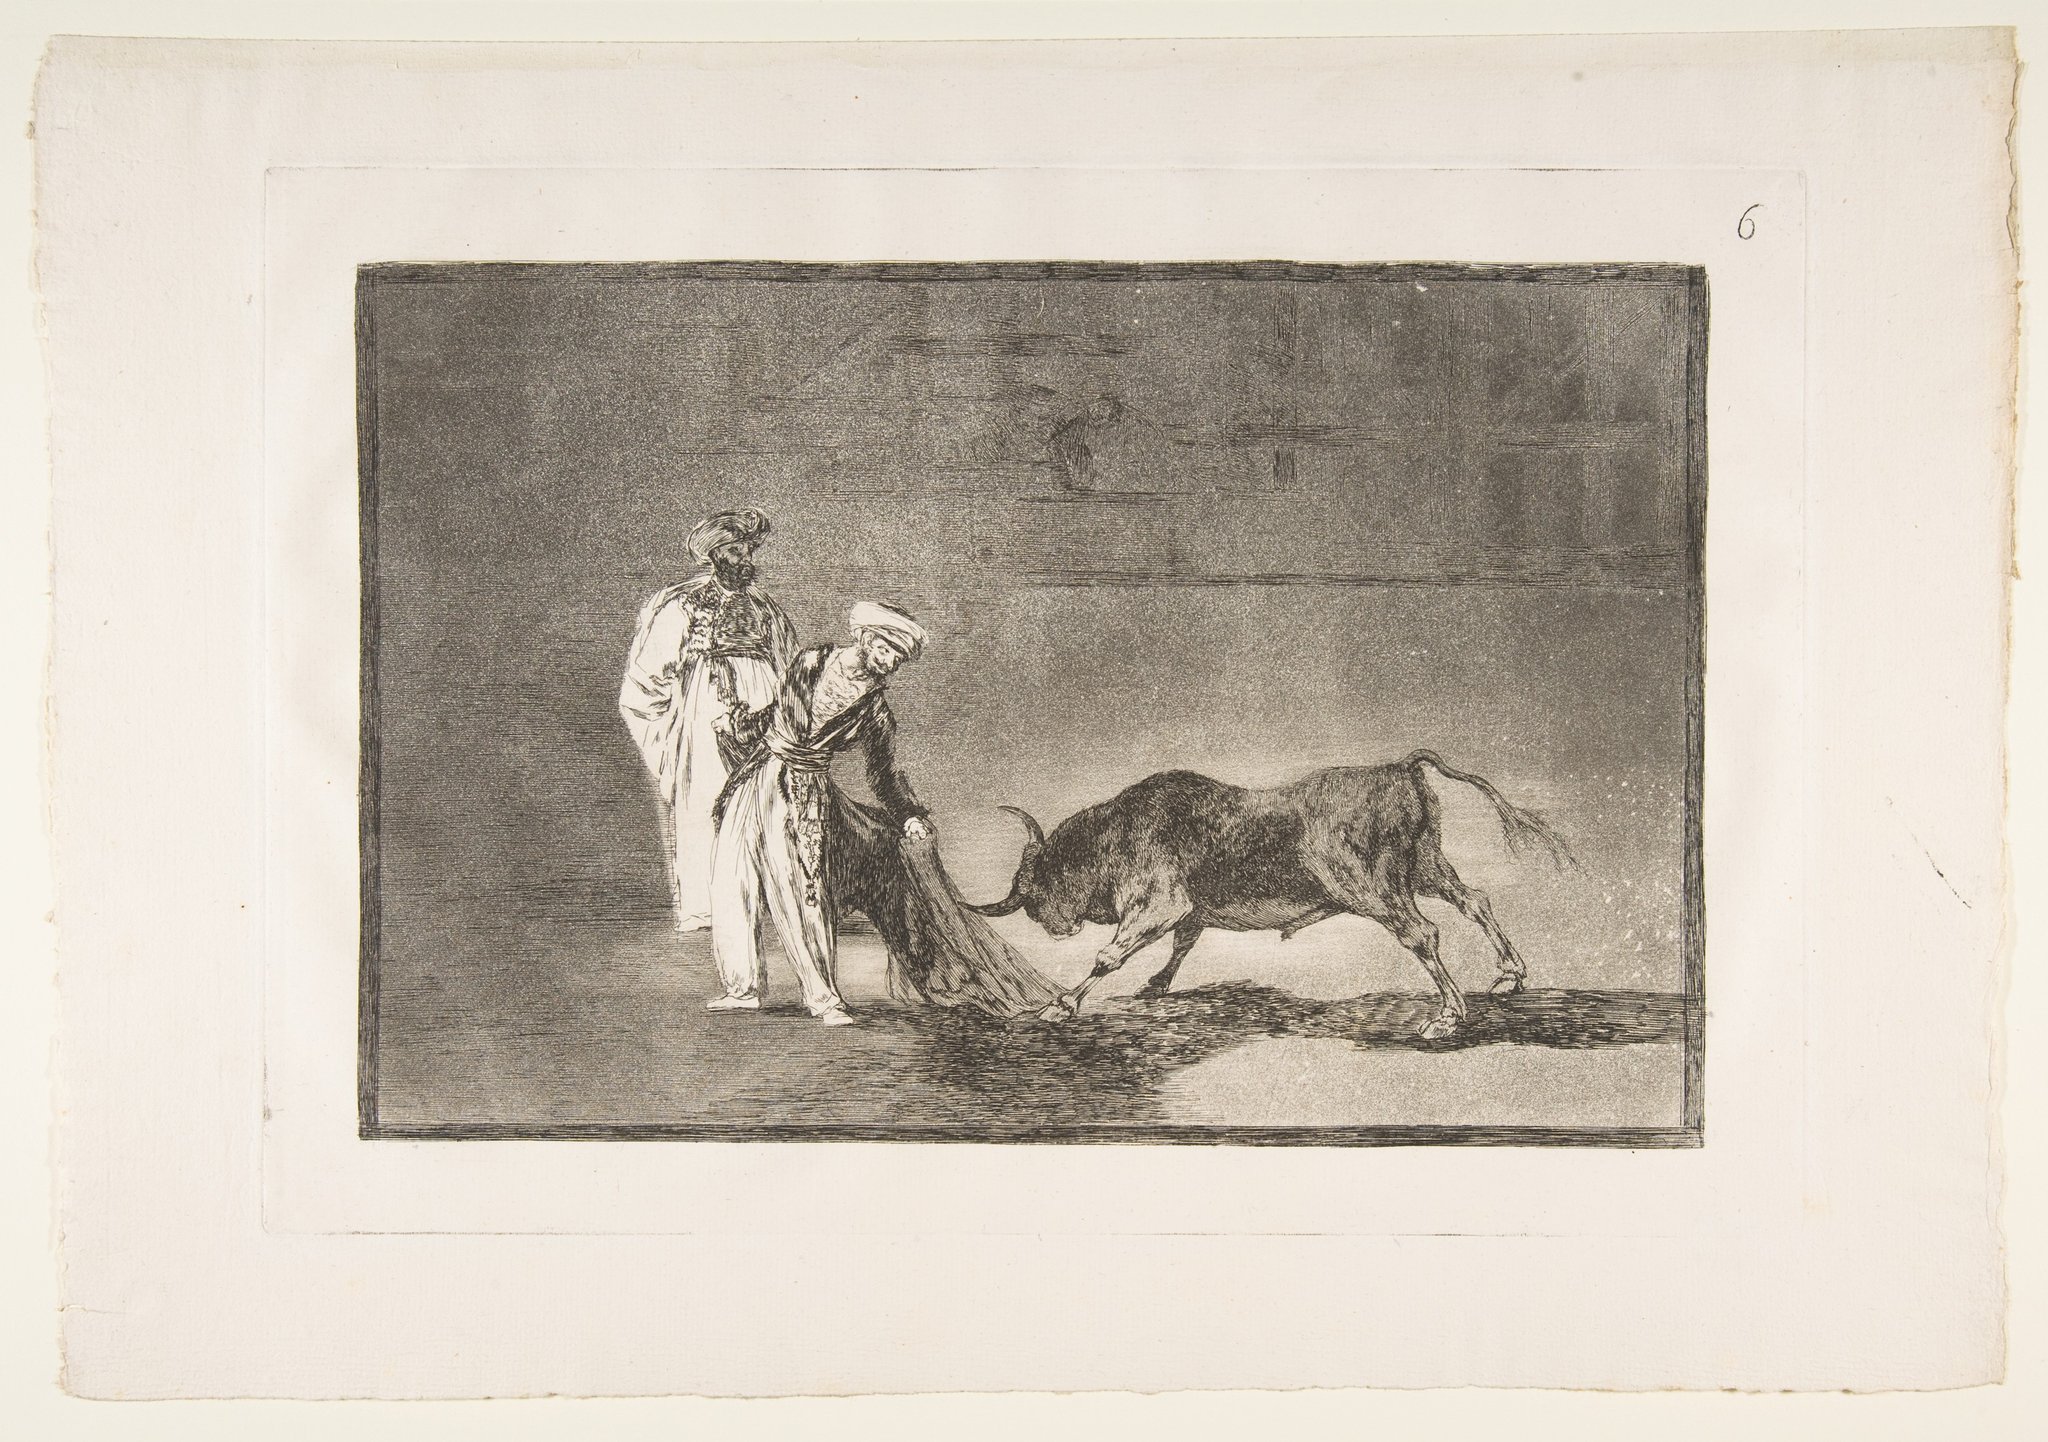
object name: print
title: Plate 6 from "La Tauromaquia": The Moors make a different play in the ring calling the bull with their burnous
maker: goya (francisco de goya y lucientes)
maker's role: artist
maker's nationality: spanish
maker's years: 1746-1828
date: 1816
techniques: aquatint, burnishing, drypoint, etching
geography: spain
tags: men,bulls